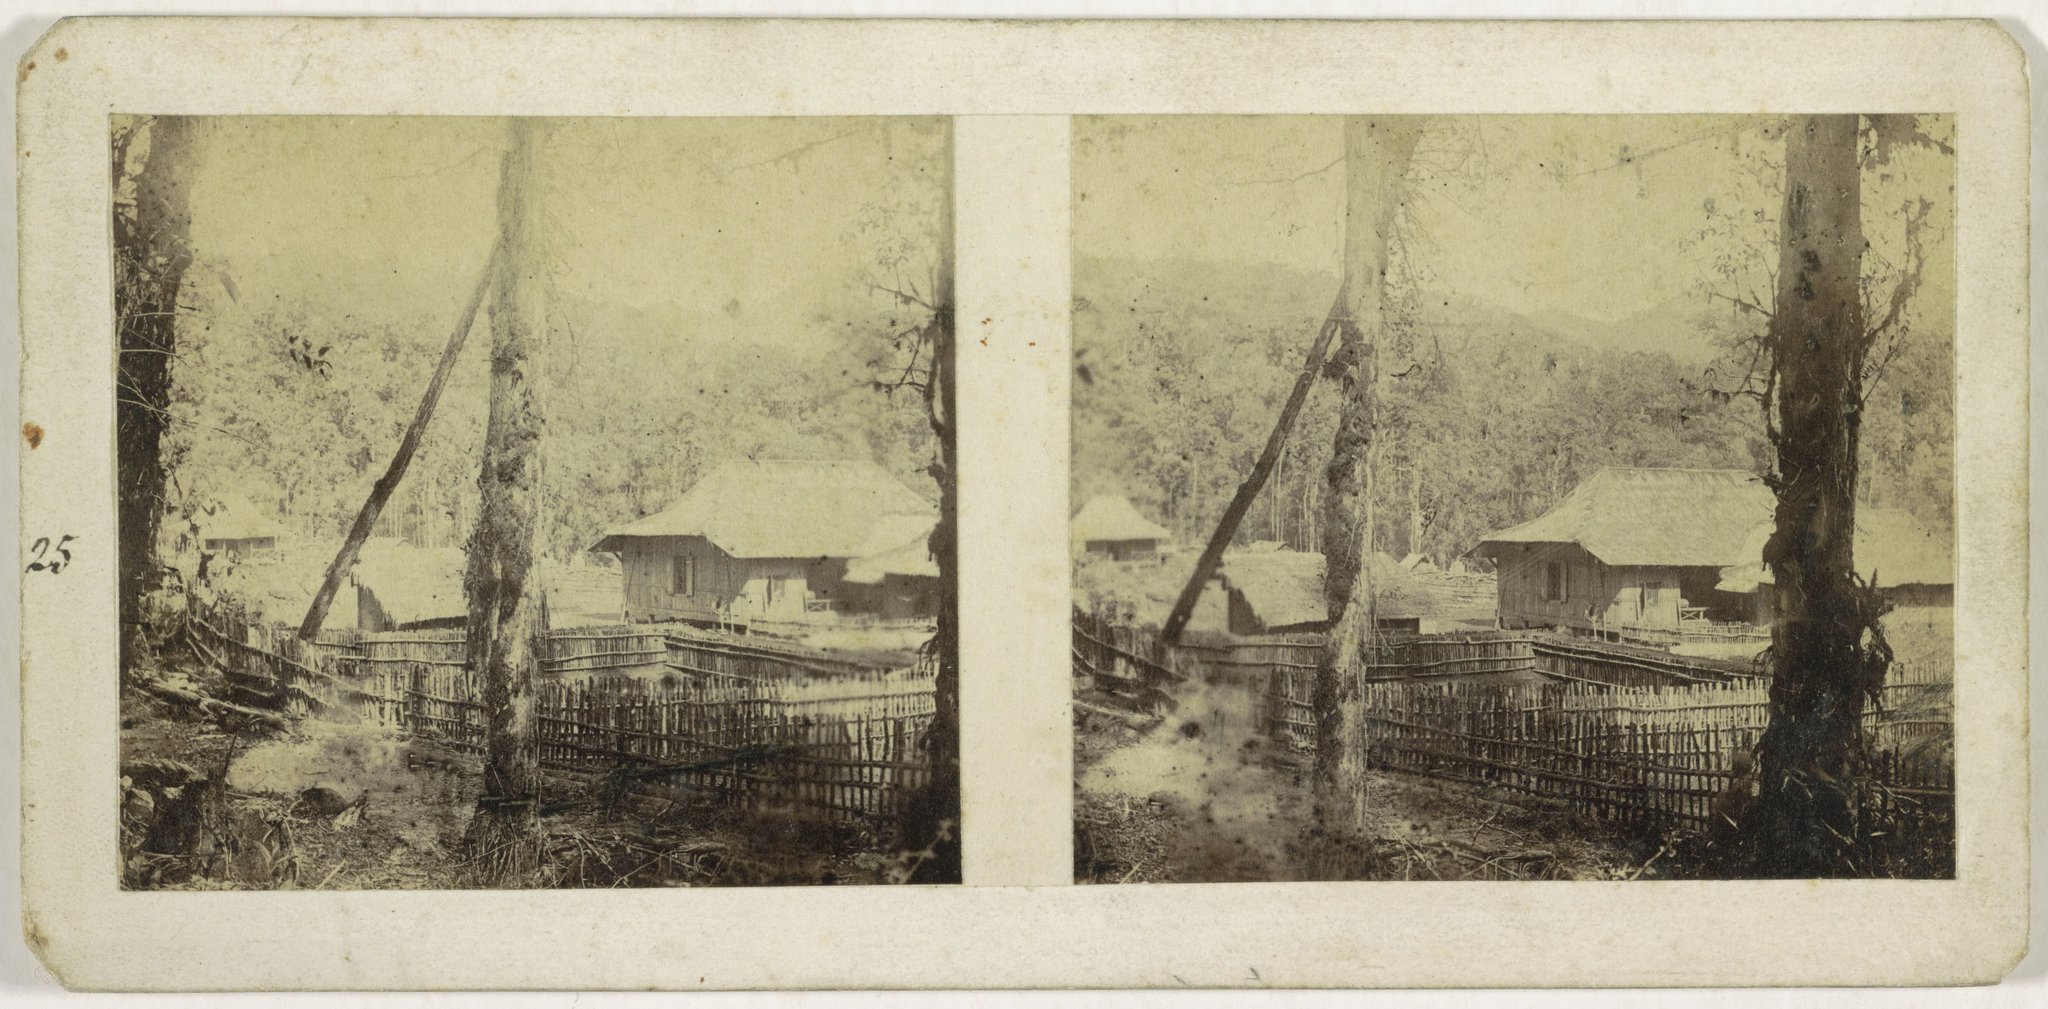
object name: stereograph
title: Javaans dorp aan de voet van de Patuha vulkaan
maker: Anonymous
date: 1868-1890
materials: cardboard, paper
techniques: albumen print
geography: java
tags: village, volcano, java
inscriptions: inscription: ‘Prantja bolang. Opzienderswoon./ bij de Kinakultuur. 5800 voet./ de Goen. Patoea in het N.W.’, number: ‘25’